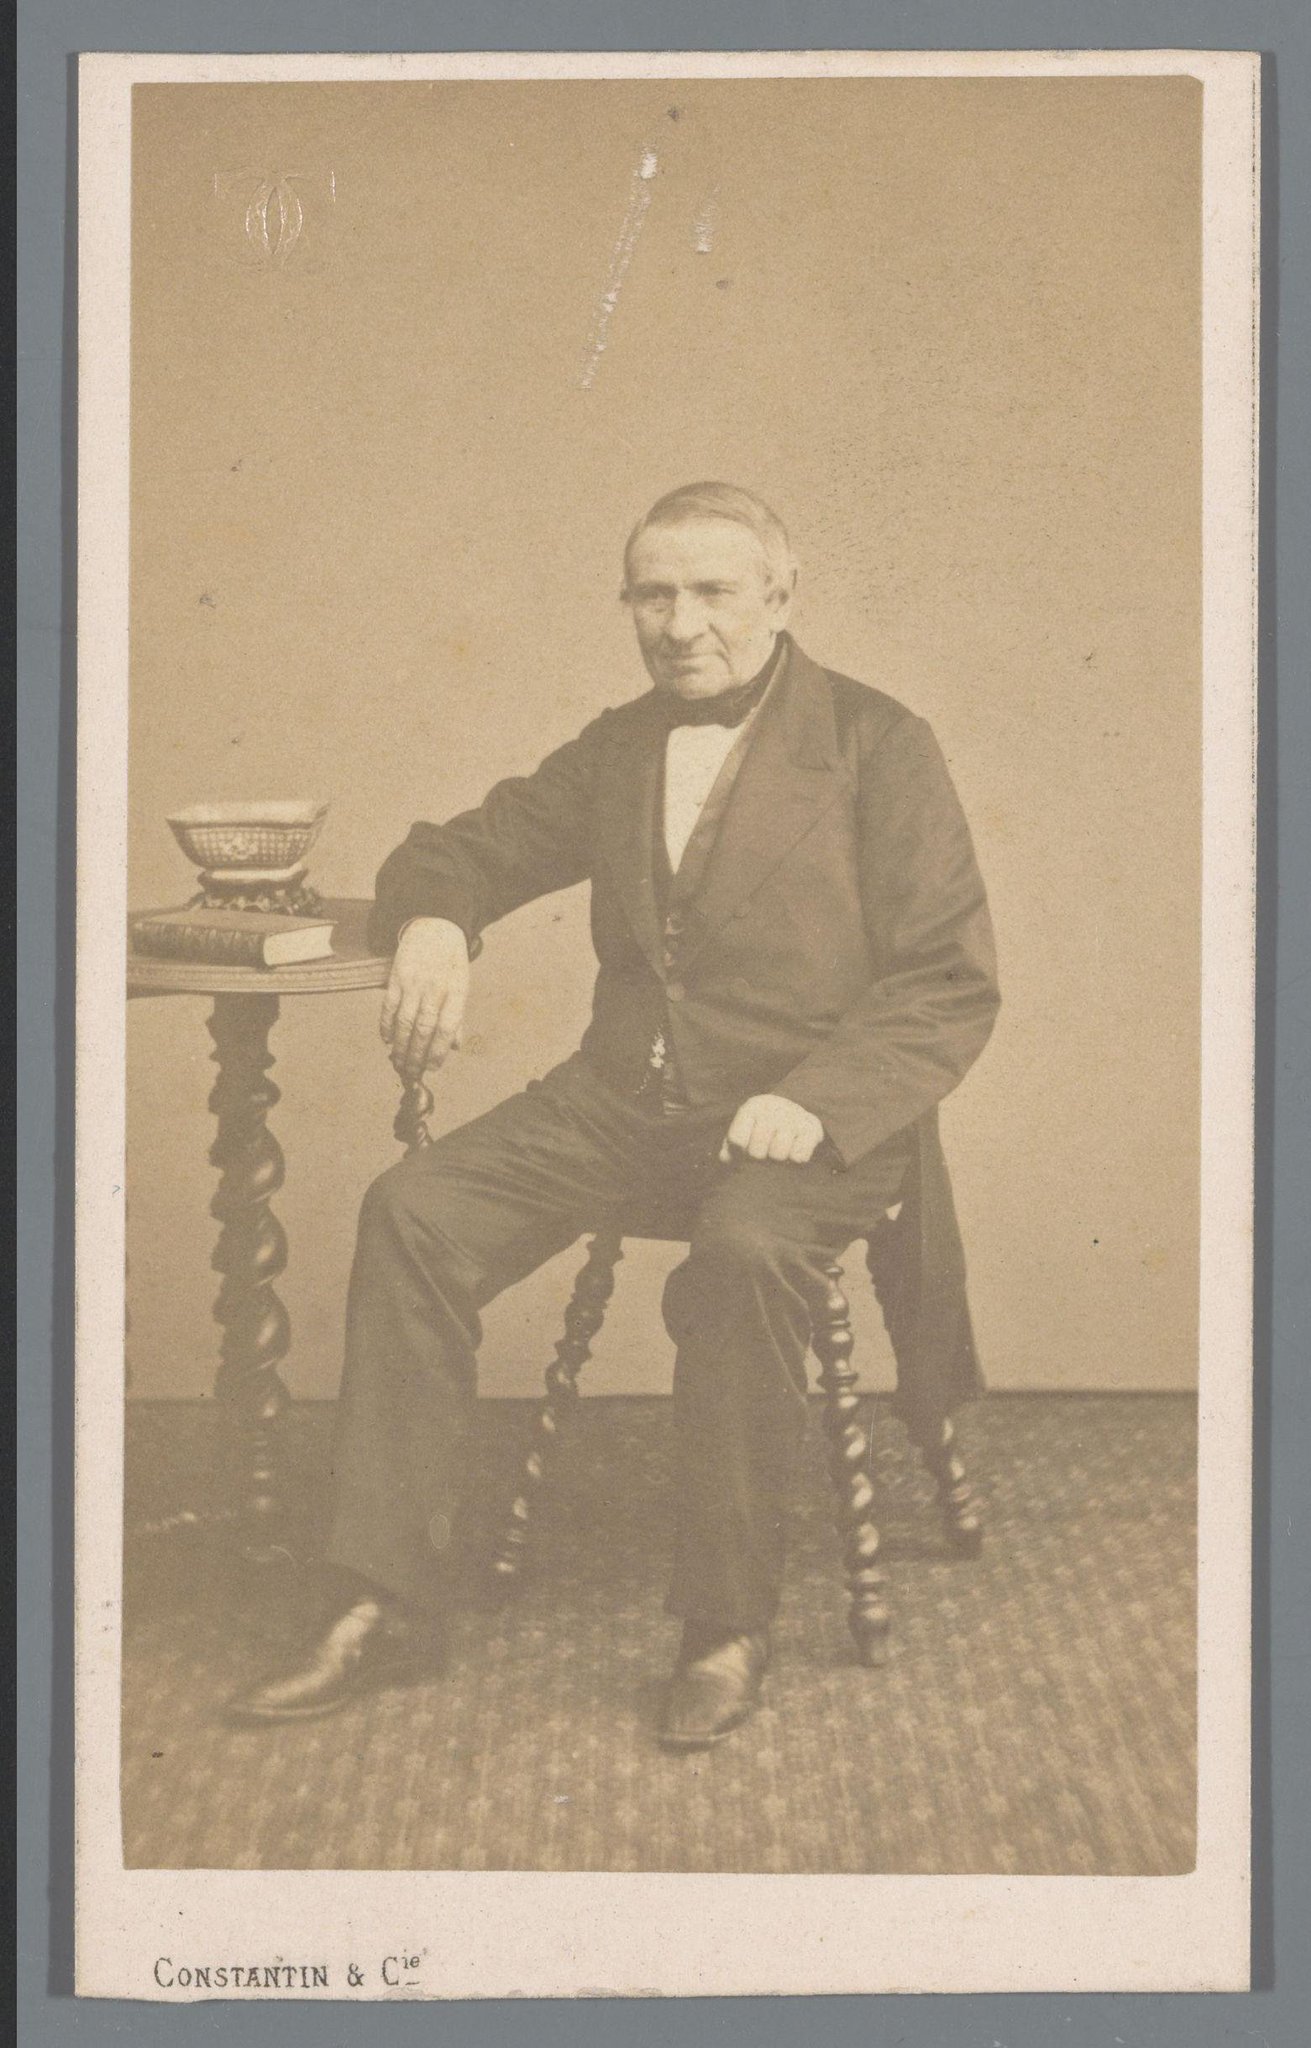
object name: carte de visite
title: Portret van een onbekende man aan een tafel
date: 1855-1885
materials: cardboard, paper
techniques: albumen print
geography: paris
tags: adult man, anonymous historical person portrayed, paris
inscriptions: inscription: ‘Constantin & Cie./ Rue Chauchat, 11./ et/ Rue de Provence, 26./ Paris.’, monogram: ‘CC’, inscription: ‘Constantin & Cie.’